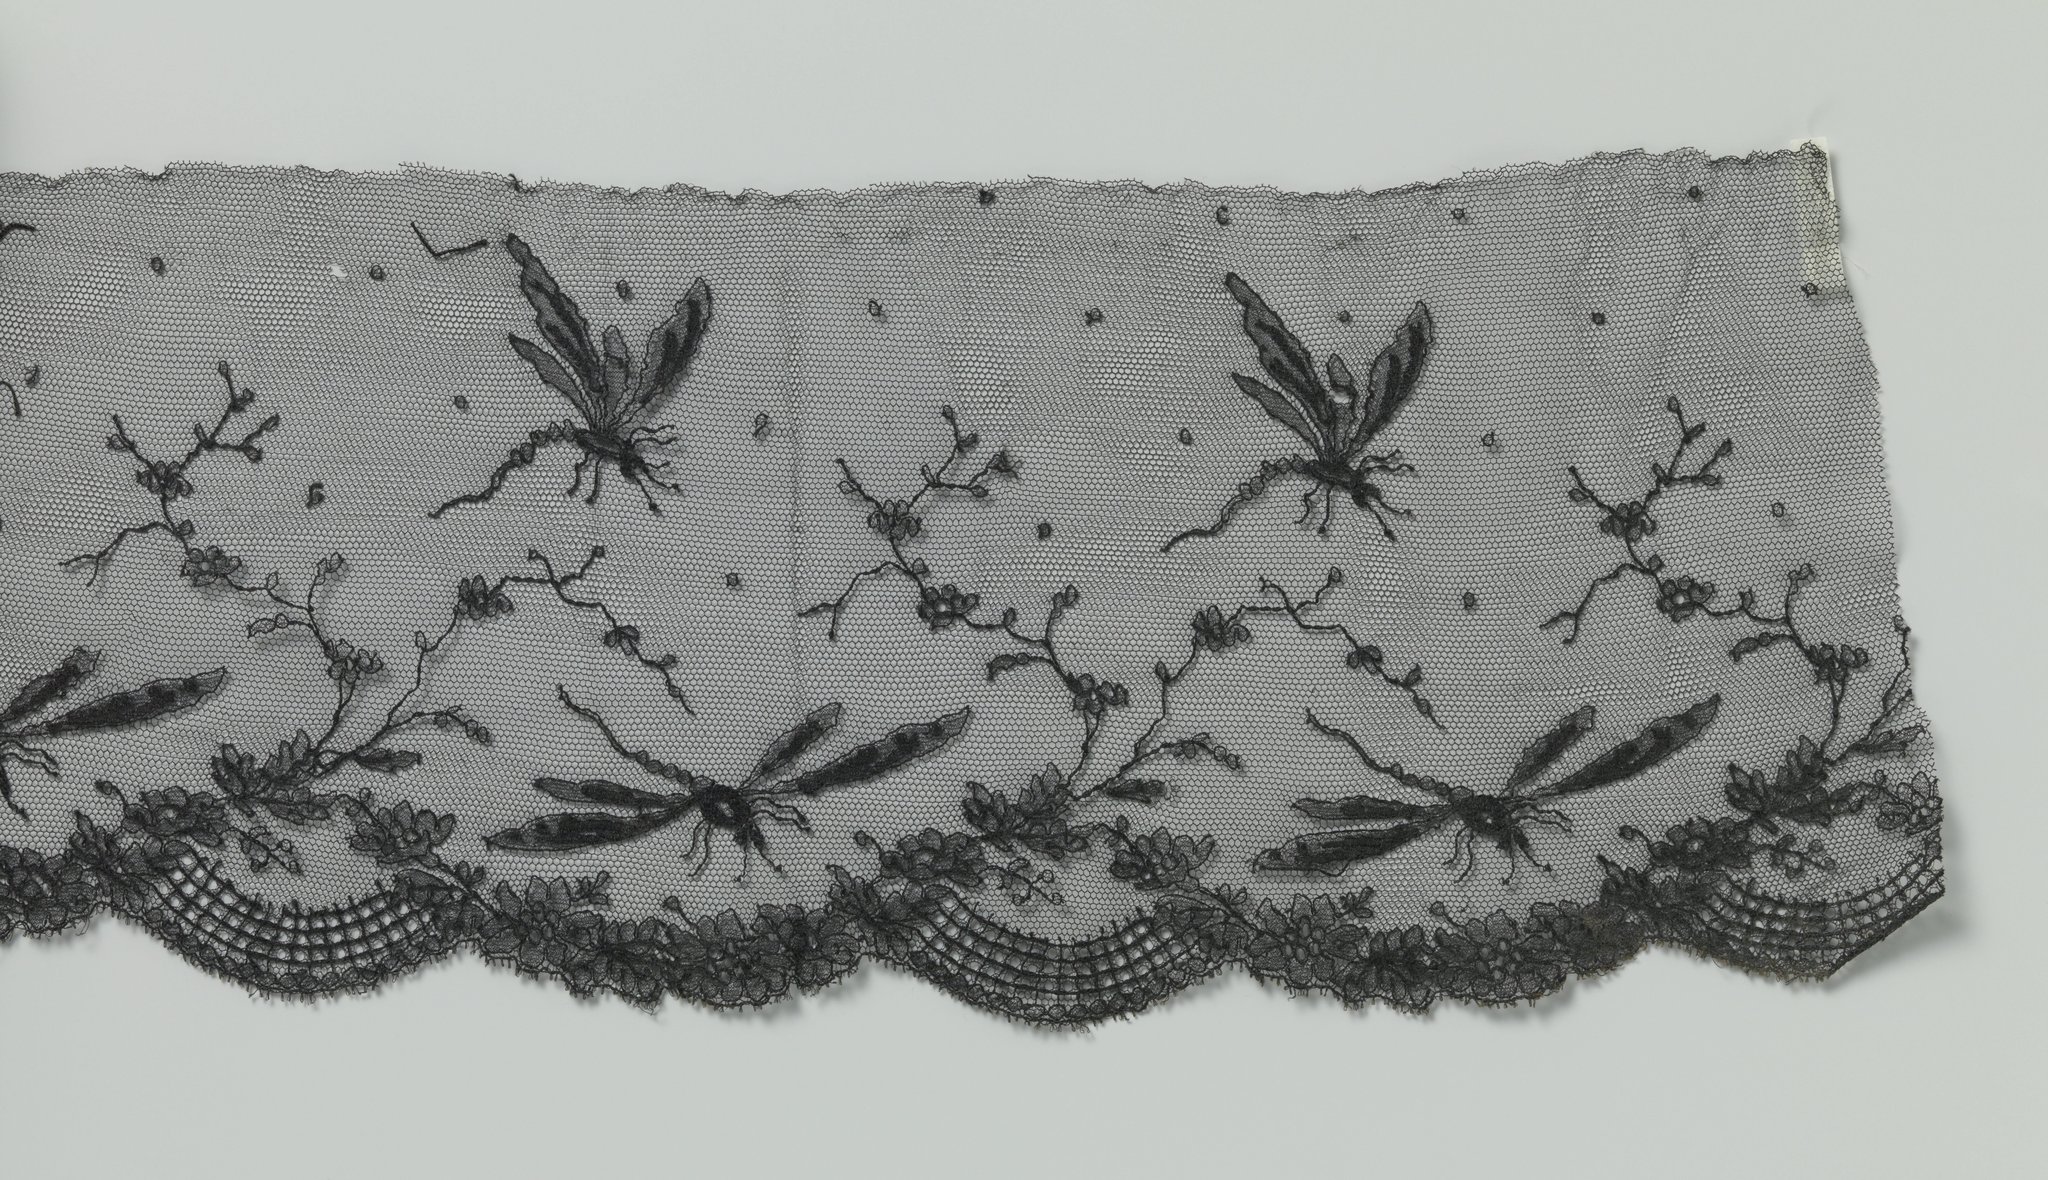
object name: strip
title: Strook zwarte machinale kant met libellen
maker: Anonymous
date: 1890-1899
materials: cotton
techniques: lace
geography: calais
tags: insects: dragon-fly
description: Strook zwarte machinale kant: machinale Chantilly-kant. Het zich herhalende patroon bestaat uit twee, bijna recht boven elkaar geplaatste, vliegende libellen. De vleugels van de bovenste libelle zijn meer omhoog gericht en die van de onderste libelle zijwaarts. Een ijle, gespleten rozentak met enkele bloempjes en blaadjes ontspringt onderaan de strook aan een golvende lijn, die bestaat uit een aaneenschakeling van rozentakjes. Onder elke golftop hangt een gebogen korte sierband met een vierkant raster. De motieven zijn voorzien van contourdraden en zijn met elkaar verbonden door een machinale tulegrond, die is bezaaid met moesjes. Als siergrond is onder andere een machinale rozengrond toegepast in de gebogen sierband en in de bloemharten. De gebogen sierband vormt onder de toppen van de doorgaande golvende rozentakjes de schulpenrand, die is afgewerkt met picots. De bovenzijde van de strook is recht afgeknipt en niet afgewerkt.